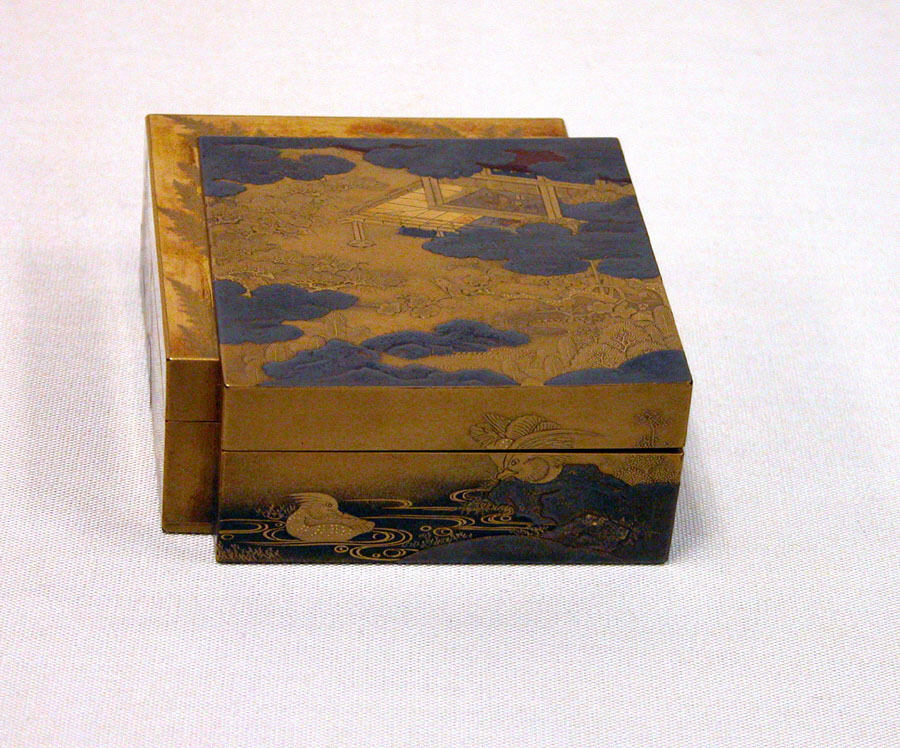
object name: kobako with tray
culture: japanese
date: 1601-1700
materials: gold, lacquer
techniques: maki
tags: birds,trees